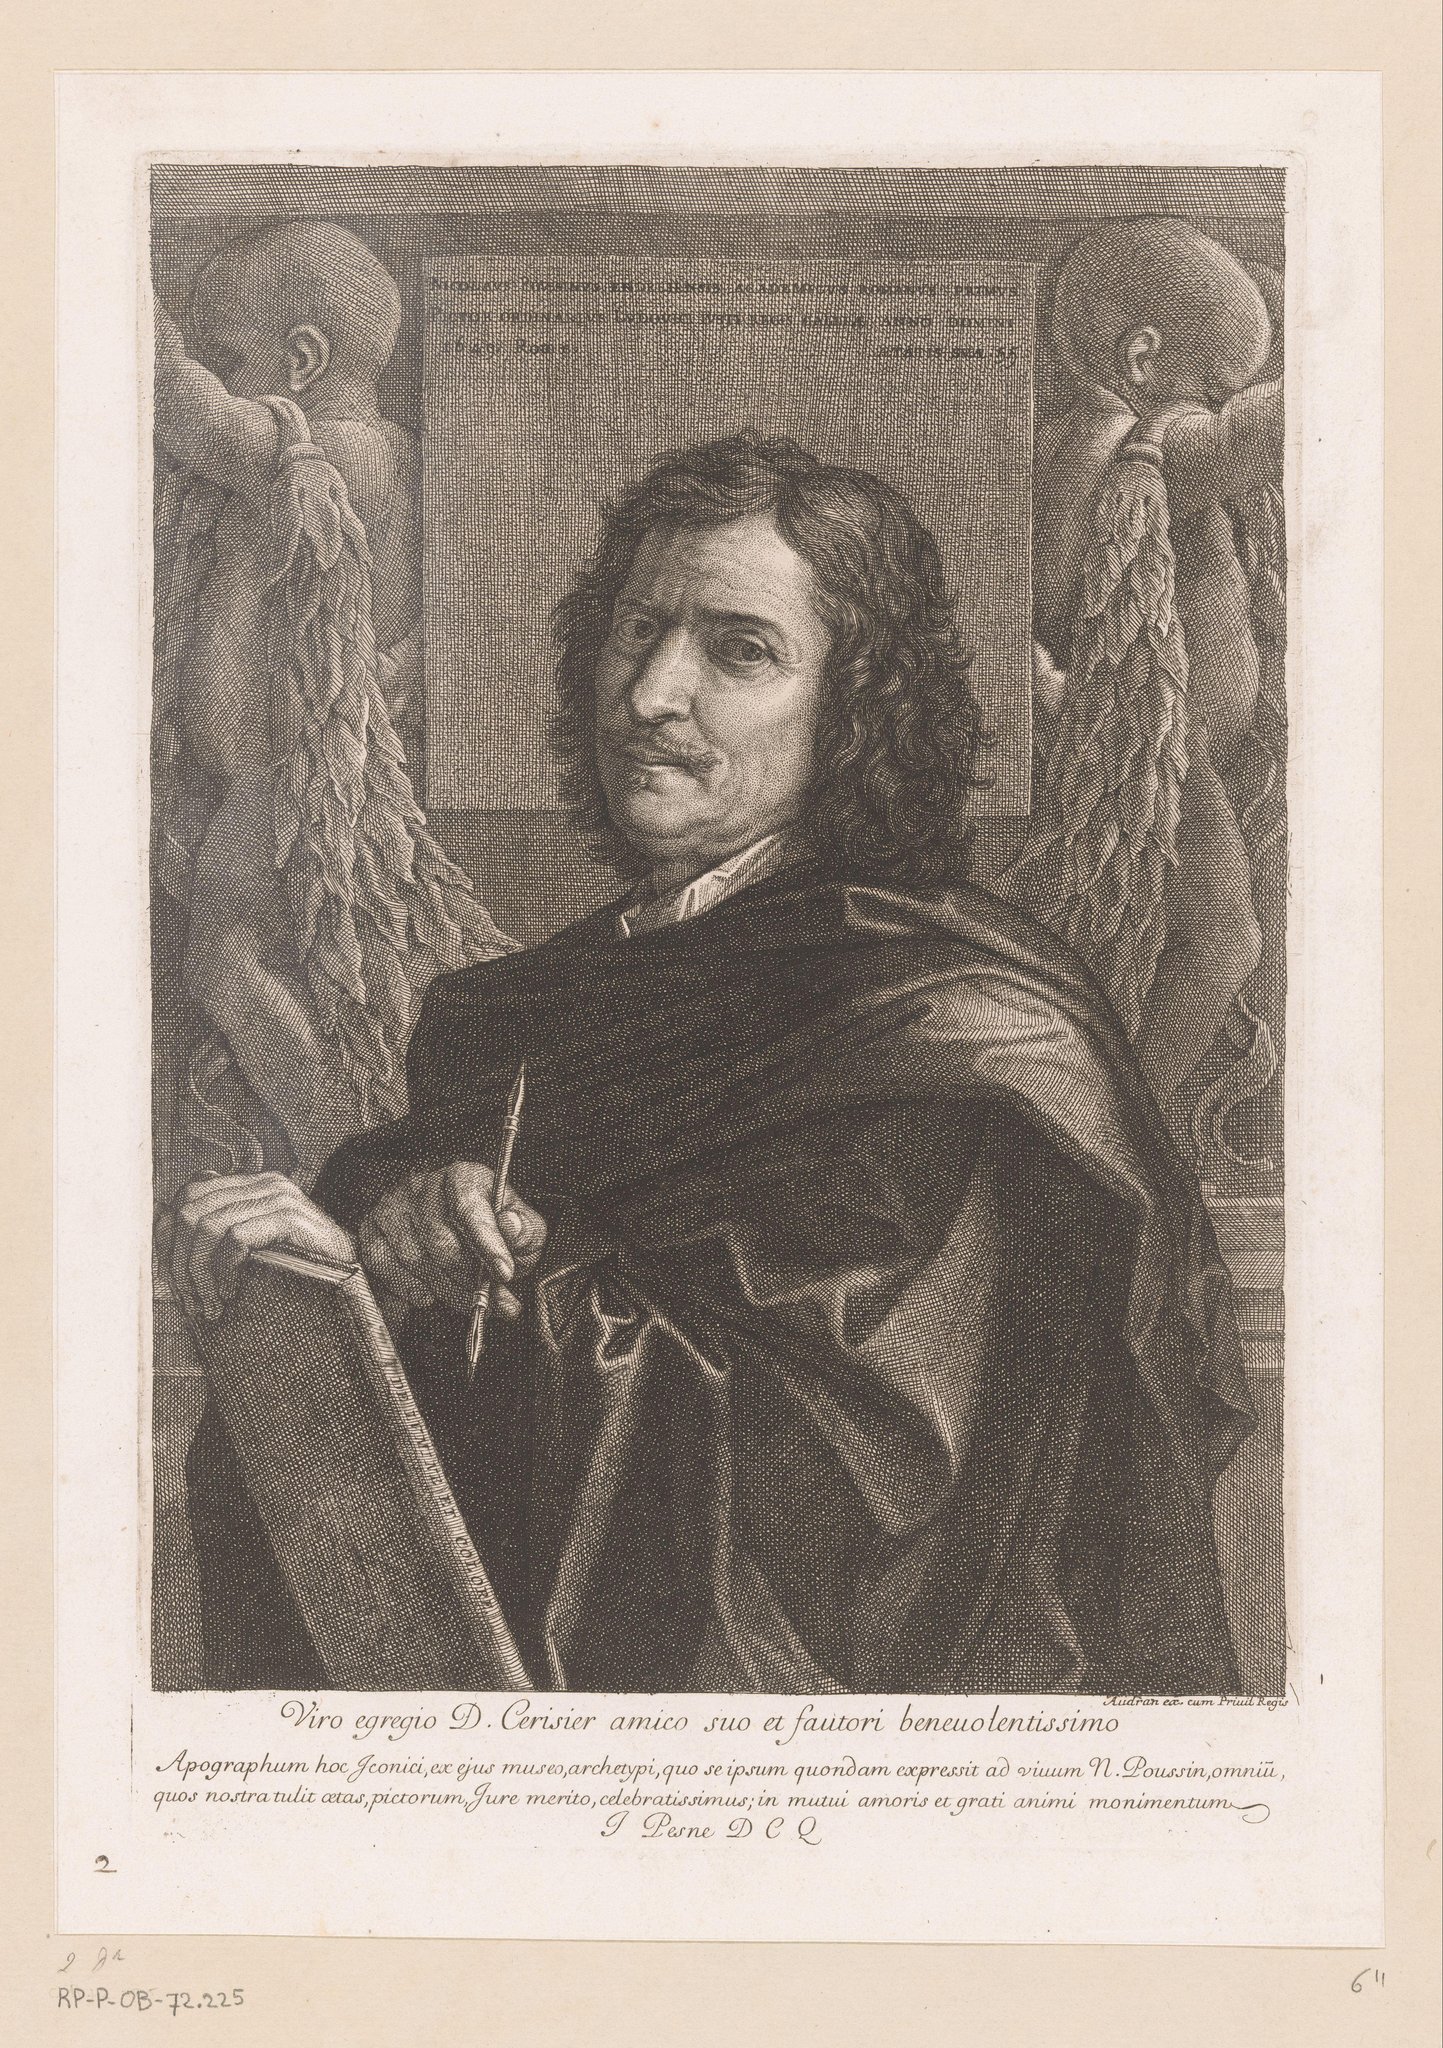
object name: print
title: Portret van Nicolas Poussin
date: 1649-1700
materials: paper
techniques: etching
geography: france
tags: rome, painter, draughtsman, nicolas poussin, historical persons, portrait, self-portrait of painter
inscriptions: collector's mark: Lugt 240